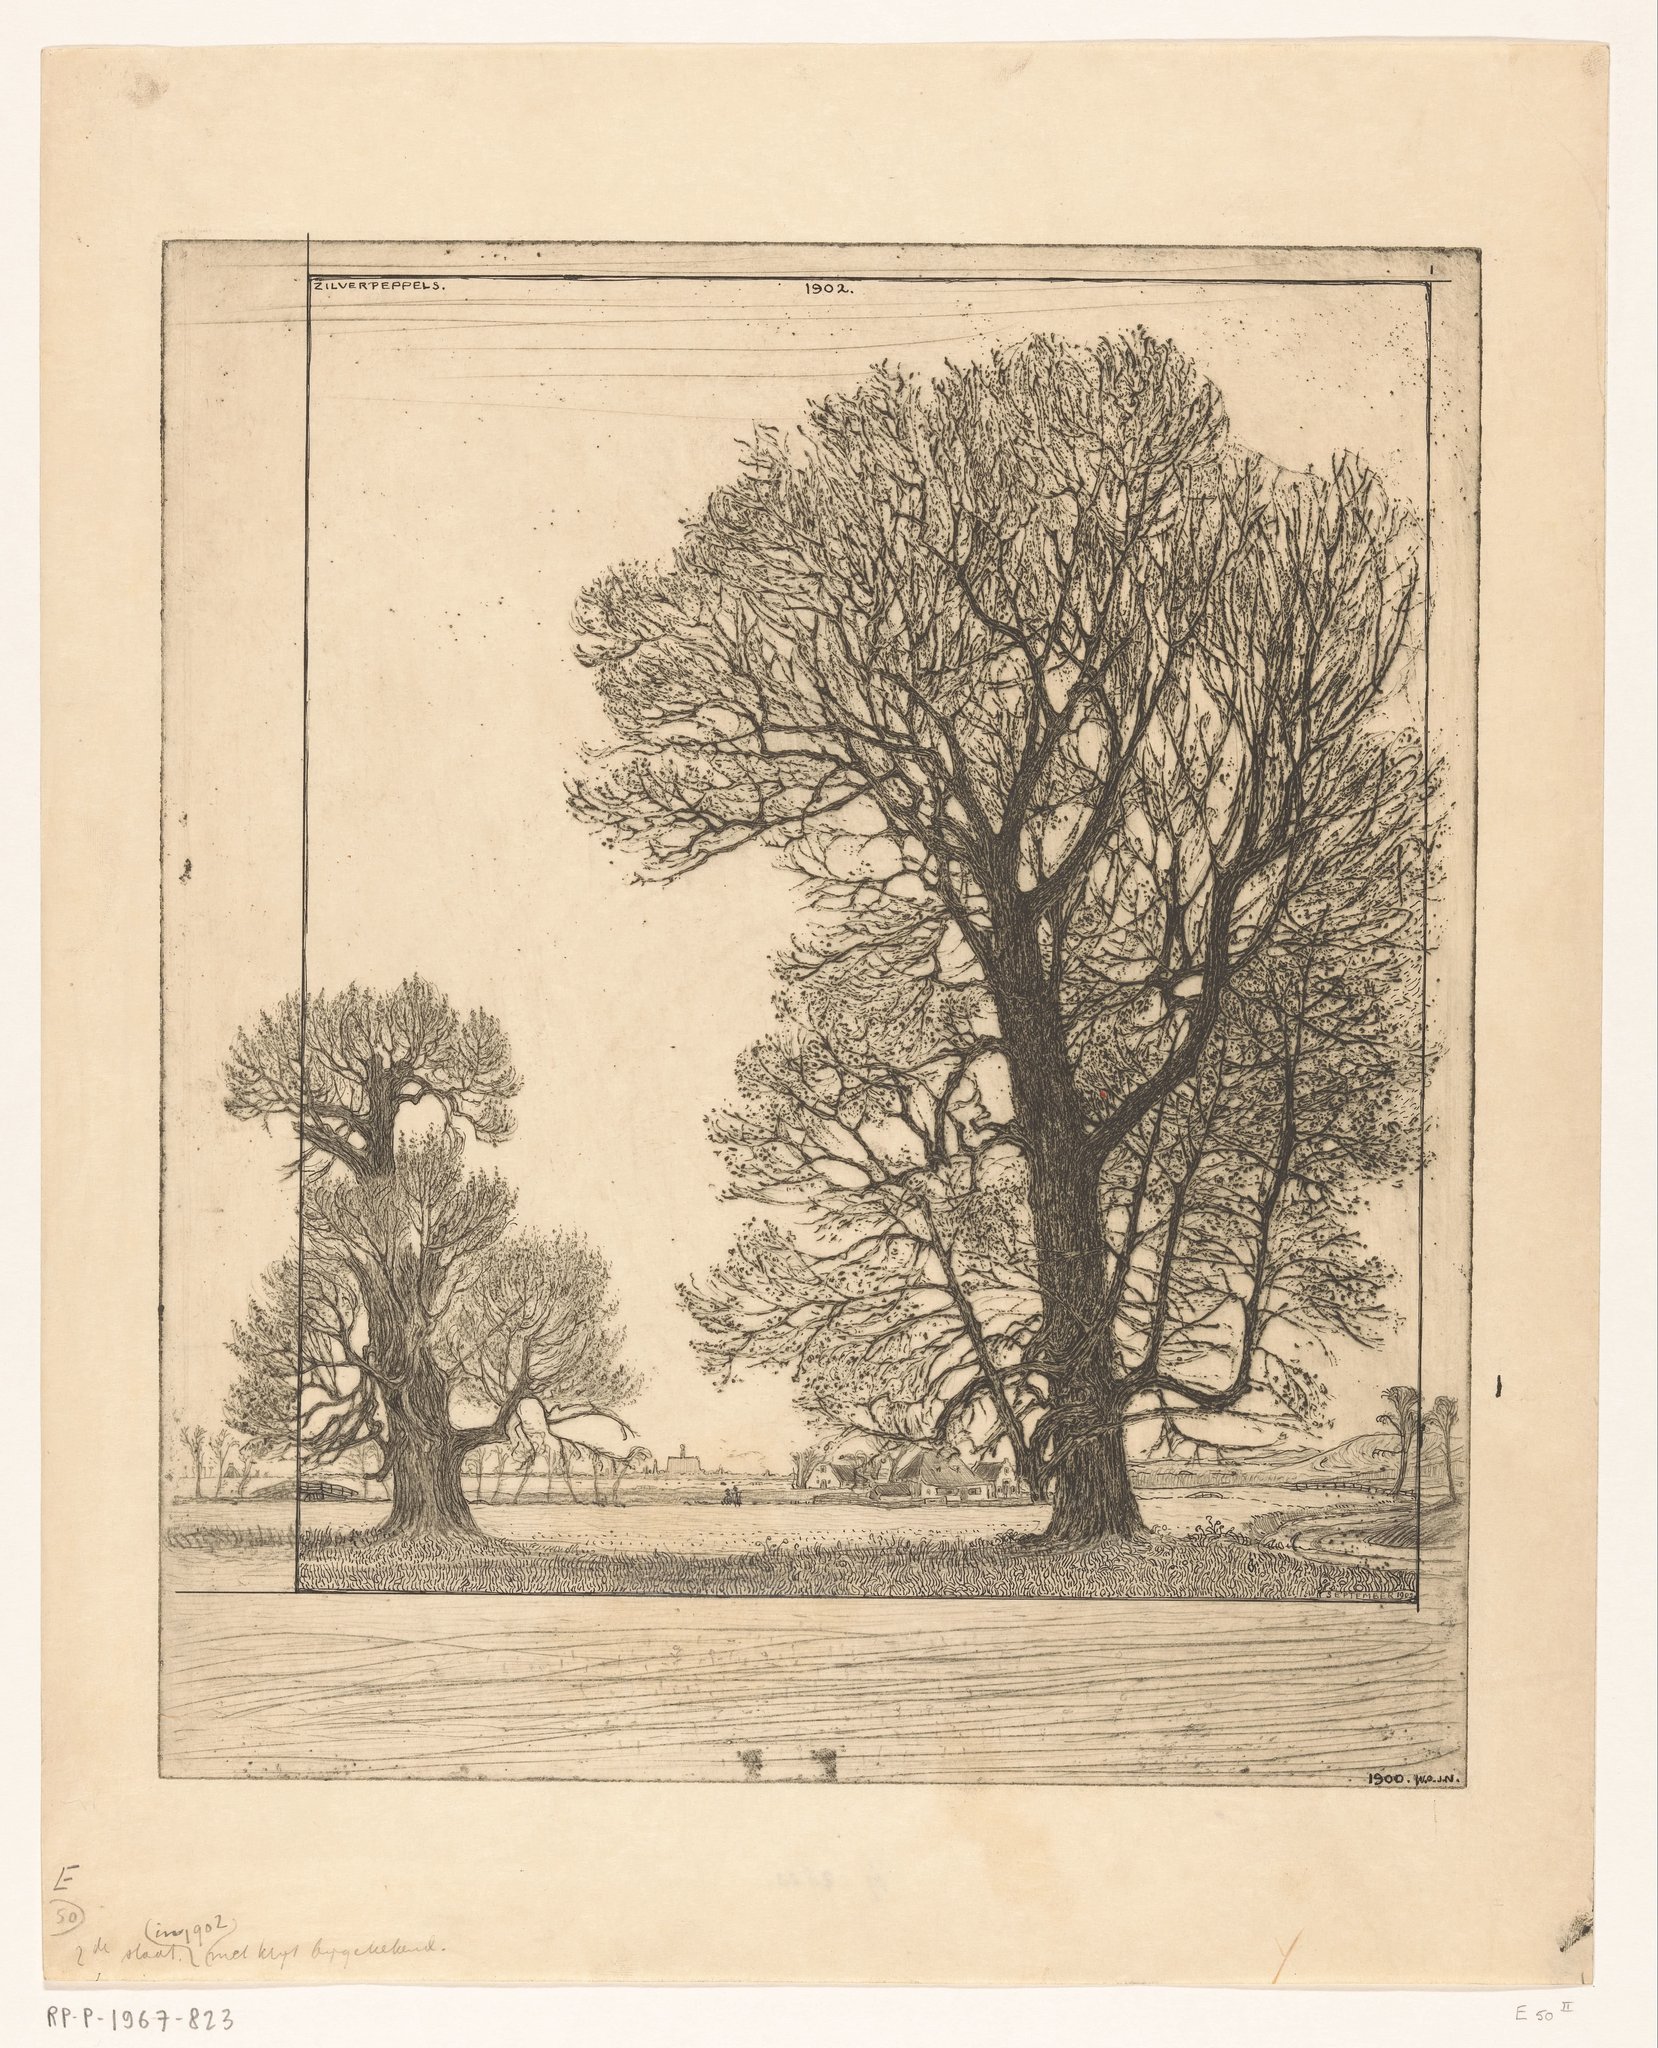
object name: print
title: Zilverpeppels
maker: wijnand otto jan nieuwenkamp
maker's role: draughtsman, print maker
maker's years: 1874-1950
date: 1900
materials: chalk, ink, paper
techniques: intaglio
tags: trees: white poplar, farm or solitary house in landscape, prospect of city, town panorama, silhouette of city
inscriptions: collector's mark: Lugt 2228, collector's mark: Lugt 2760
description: Op de achtergrond een boerderij en het silhouet van de Grote of Sint-Bavokerk in Haarlem.